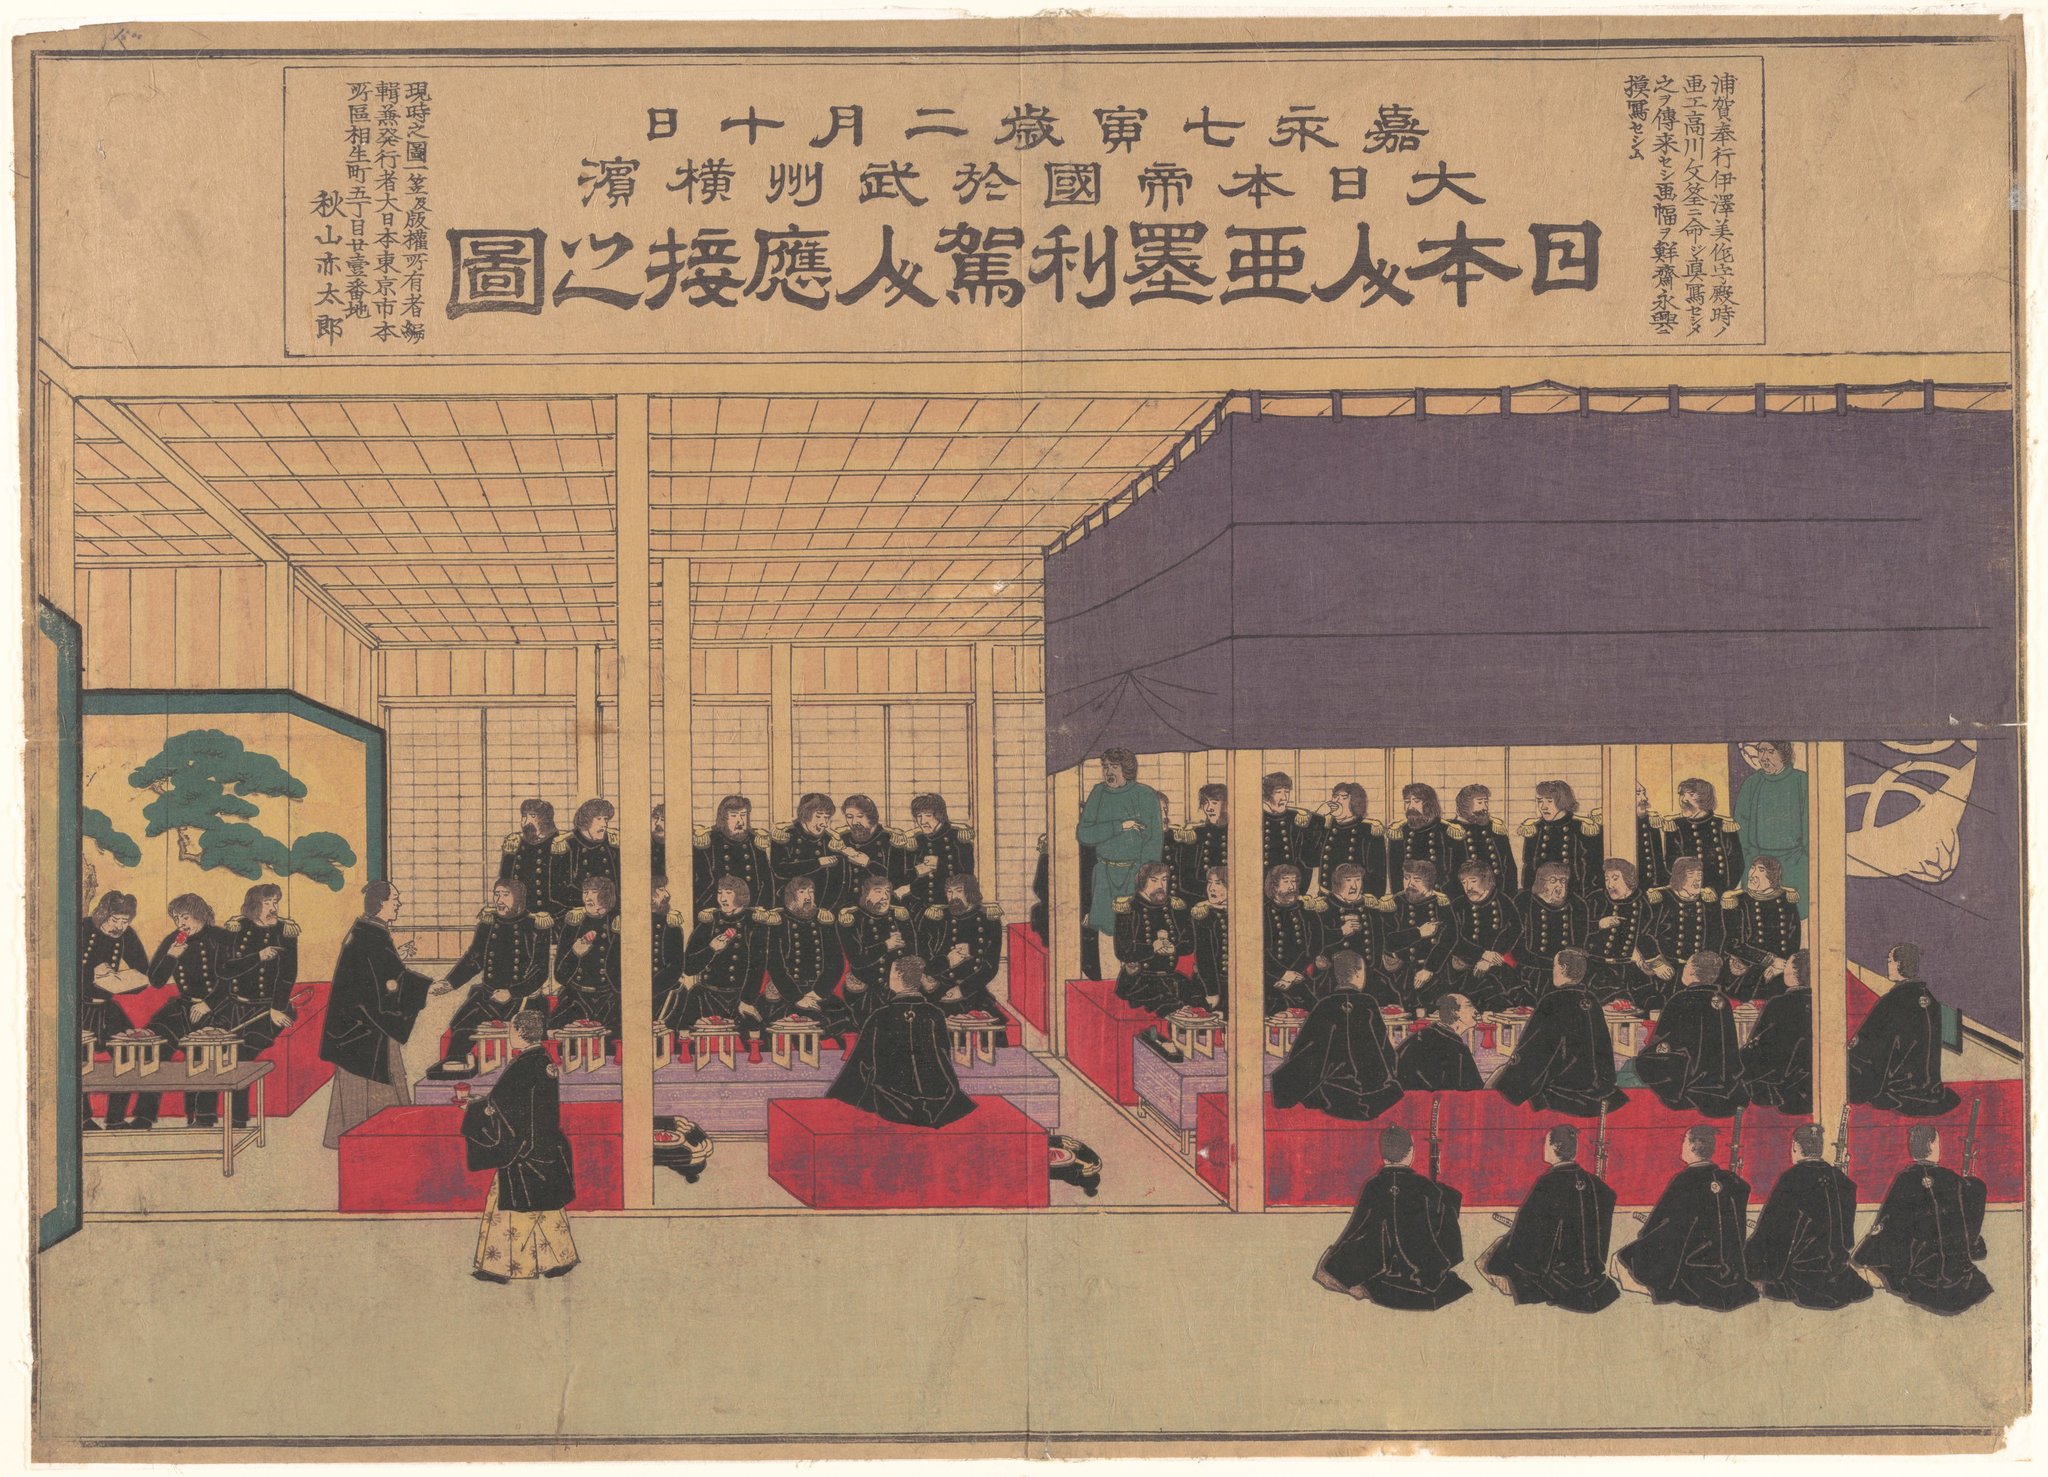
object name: print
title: Reception by the Japanese of the Americans at Yokohama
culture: japanese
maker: sensai eiko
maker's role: artist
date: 1870-1879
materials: ink, paper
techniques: woodblock print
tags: men,ceremony